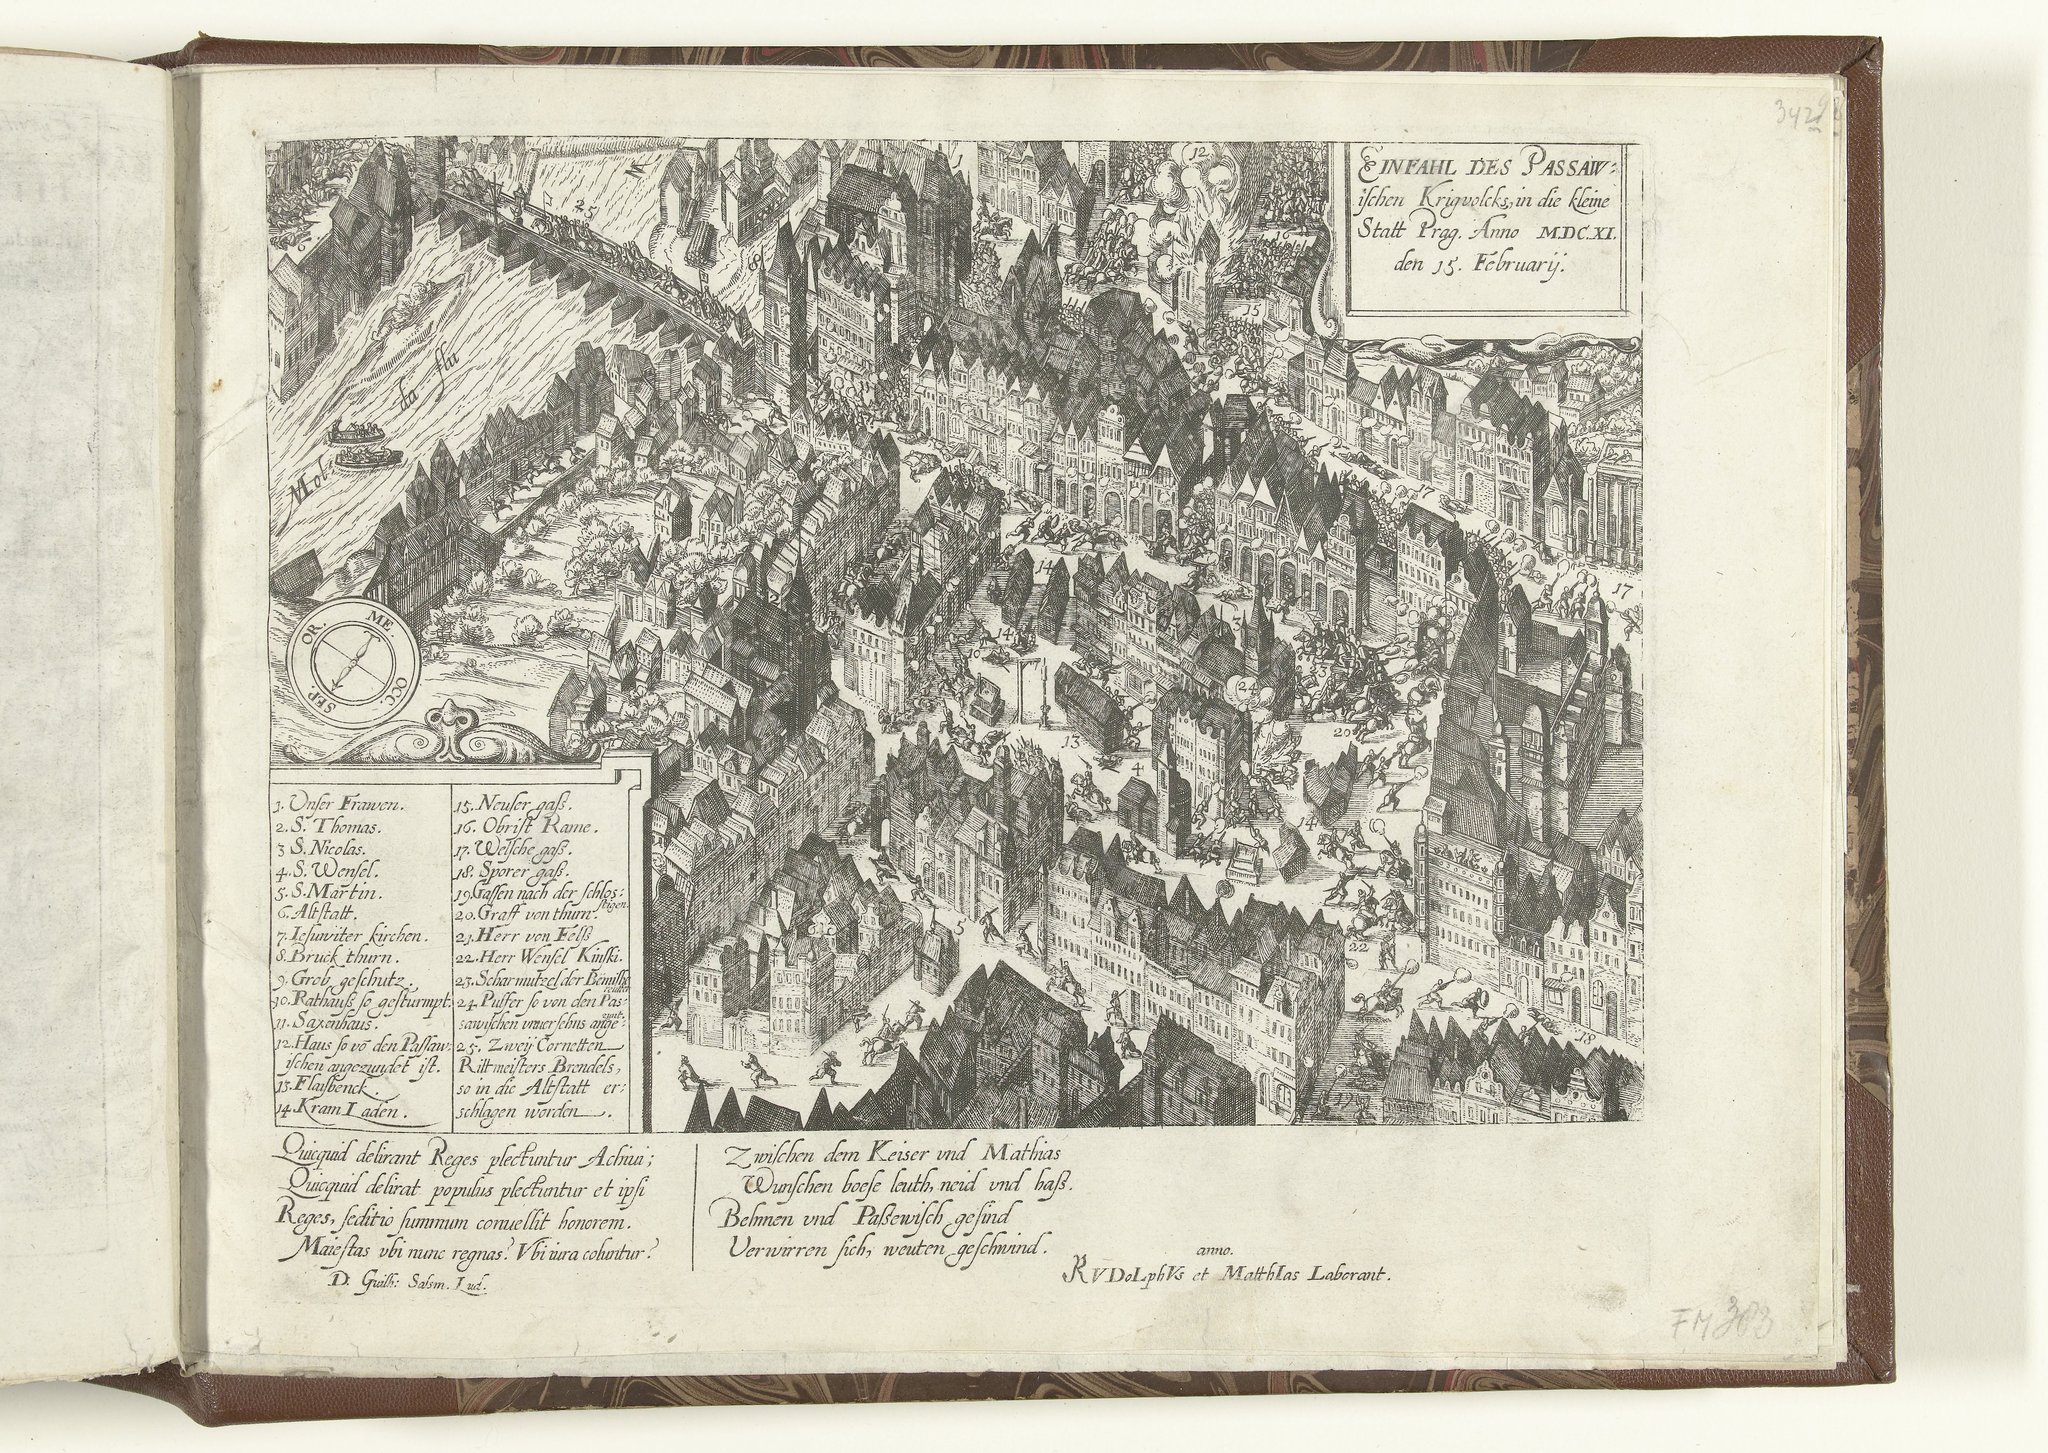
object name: print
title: Serie 10: Nederlandse en Buitenlandse Gebeurtenissen, 1587-1612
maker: frans hogenberg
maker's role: print maker, publisher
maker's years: 1538-1590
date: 1611-1613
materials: paper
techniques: etching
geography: cologne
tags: battle, fighting in general, prague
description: Inval van het Passause leger in Praag, 15 februari 1611. Met onderschrift van 4 regels in het Latijn en 4 regels in het Duits. Linksonder een cartouche met de legenda 1-25. Ongenummerd.